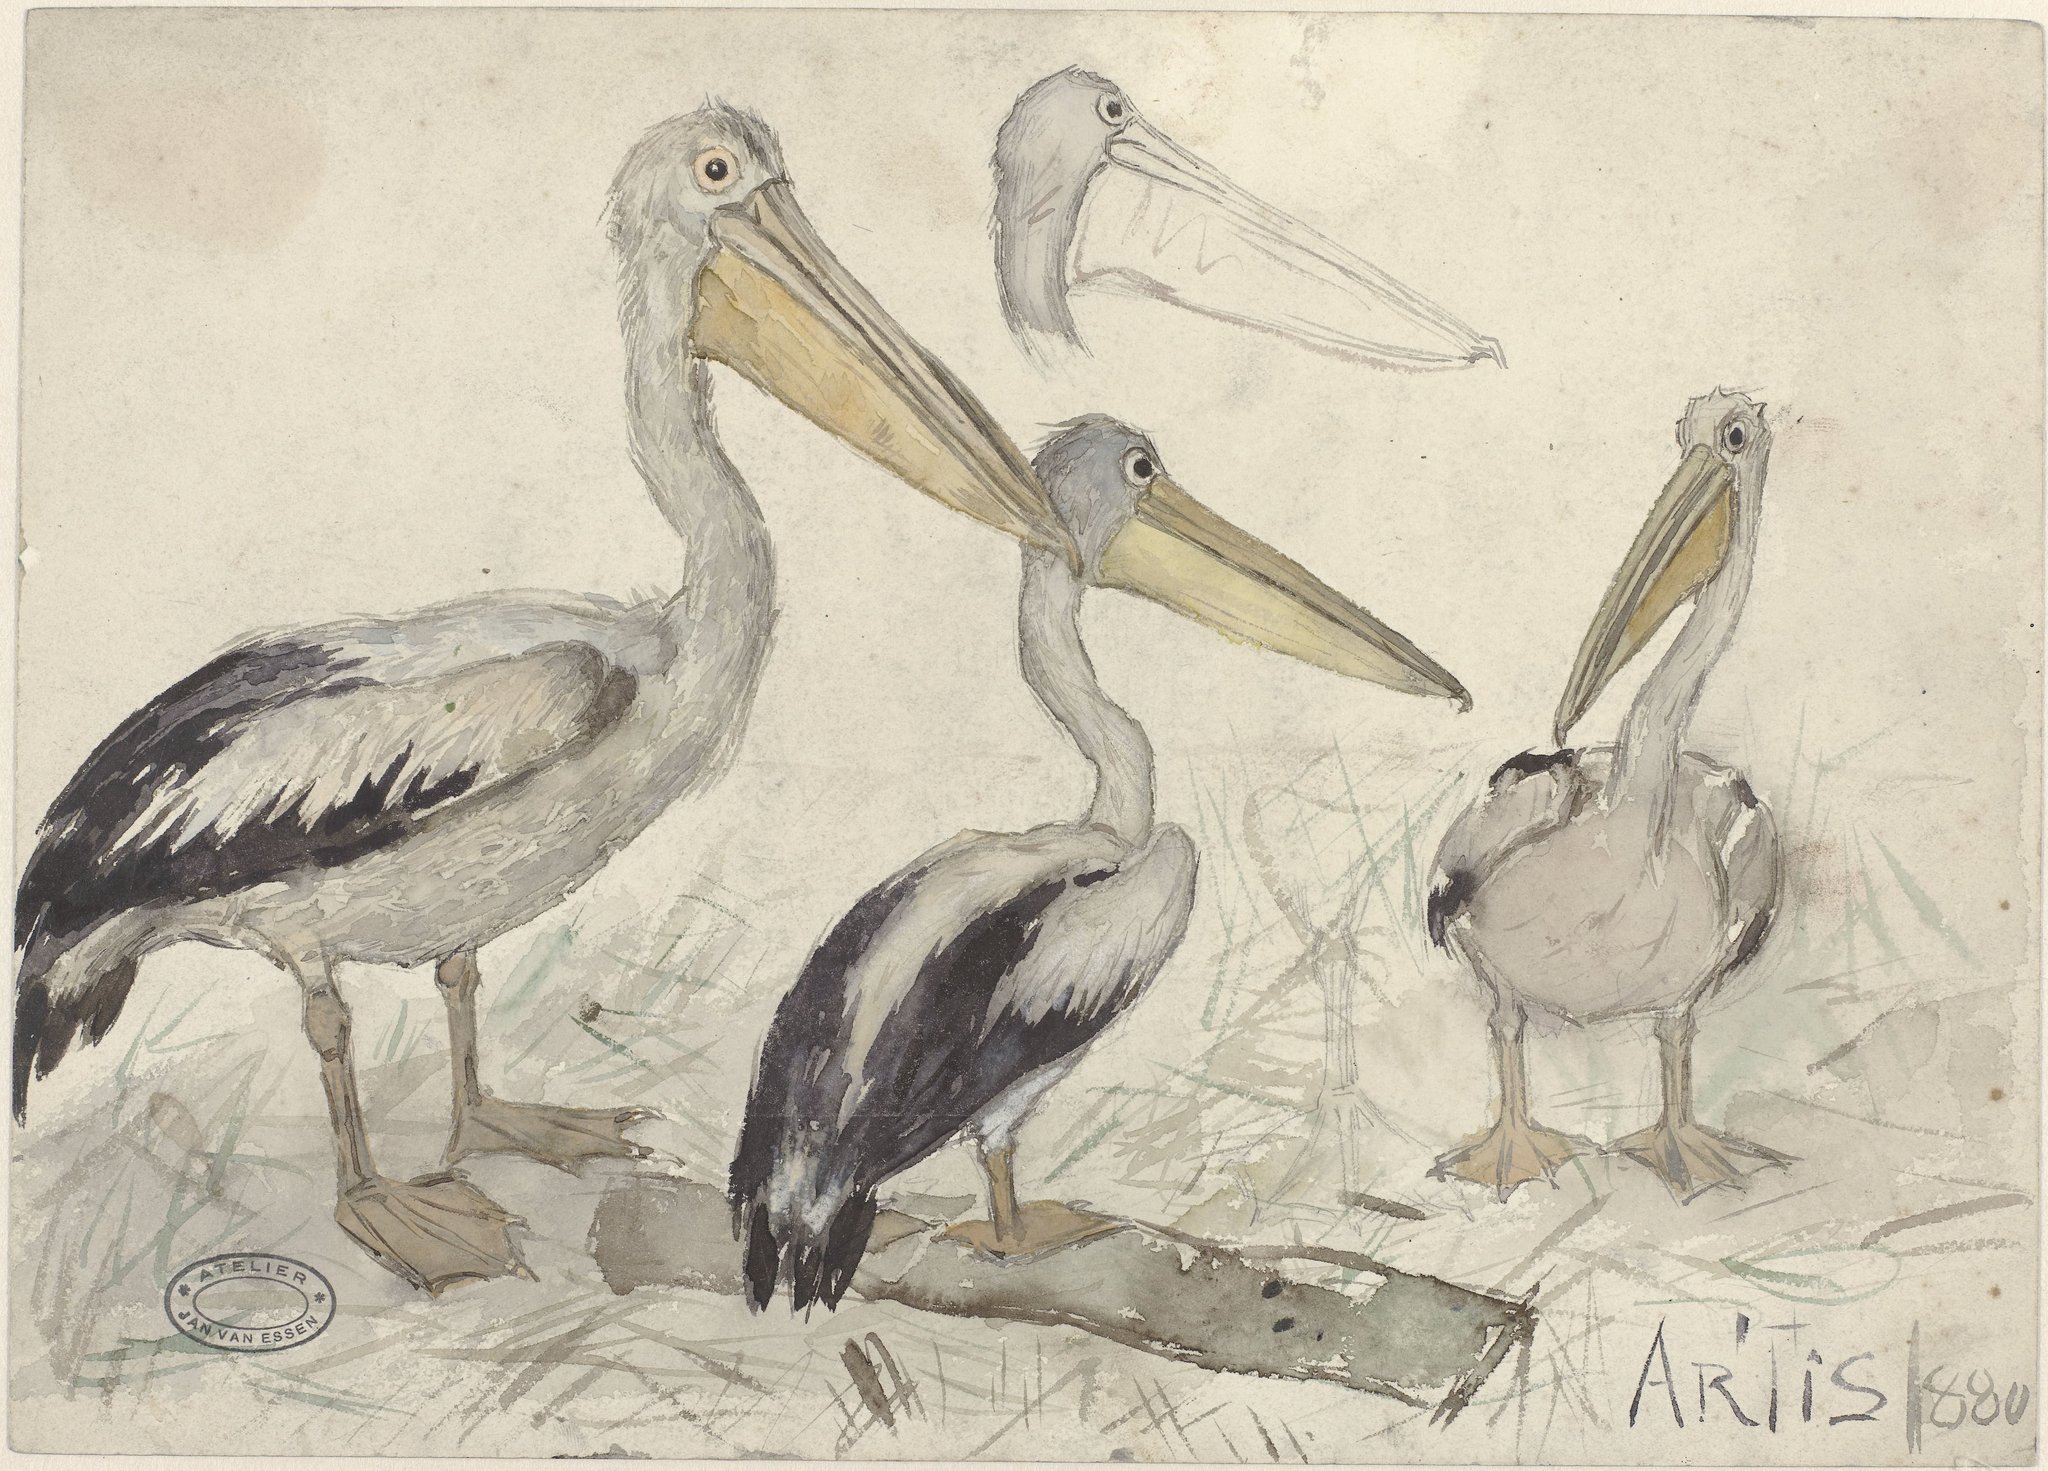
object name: drawing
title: Pelicans in Artis Zoo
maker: jan van essen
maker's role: draughtsman, print maker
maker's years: 1854-1936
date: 1880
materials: chalk, paper, watercolor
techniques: brush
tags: water-birds: pelican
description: The Amsterdam artist Jan van Essen took the tram daily to Artis to study the animals. He was especially fond of the lions and large birds, such as pelicans, vultures and marabous. The sketches he made on the spot served as models in composing his paintings. He also derived inspiration from the work of the British artist and sculptor John Macallan Swan.